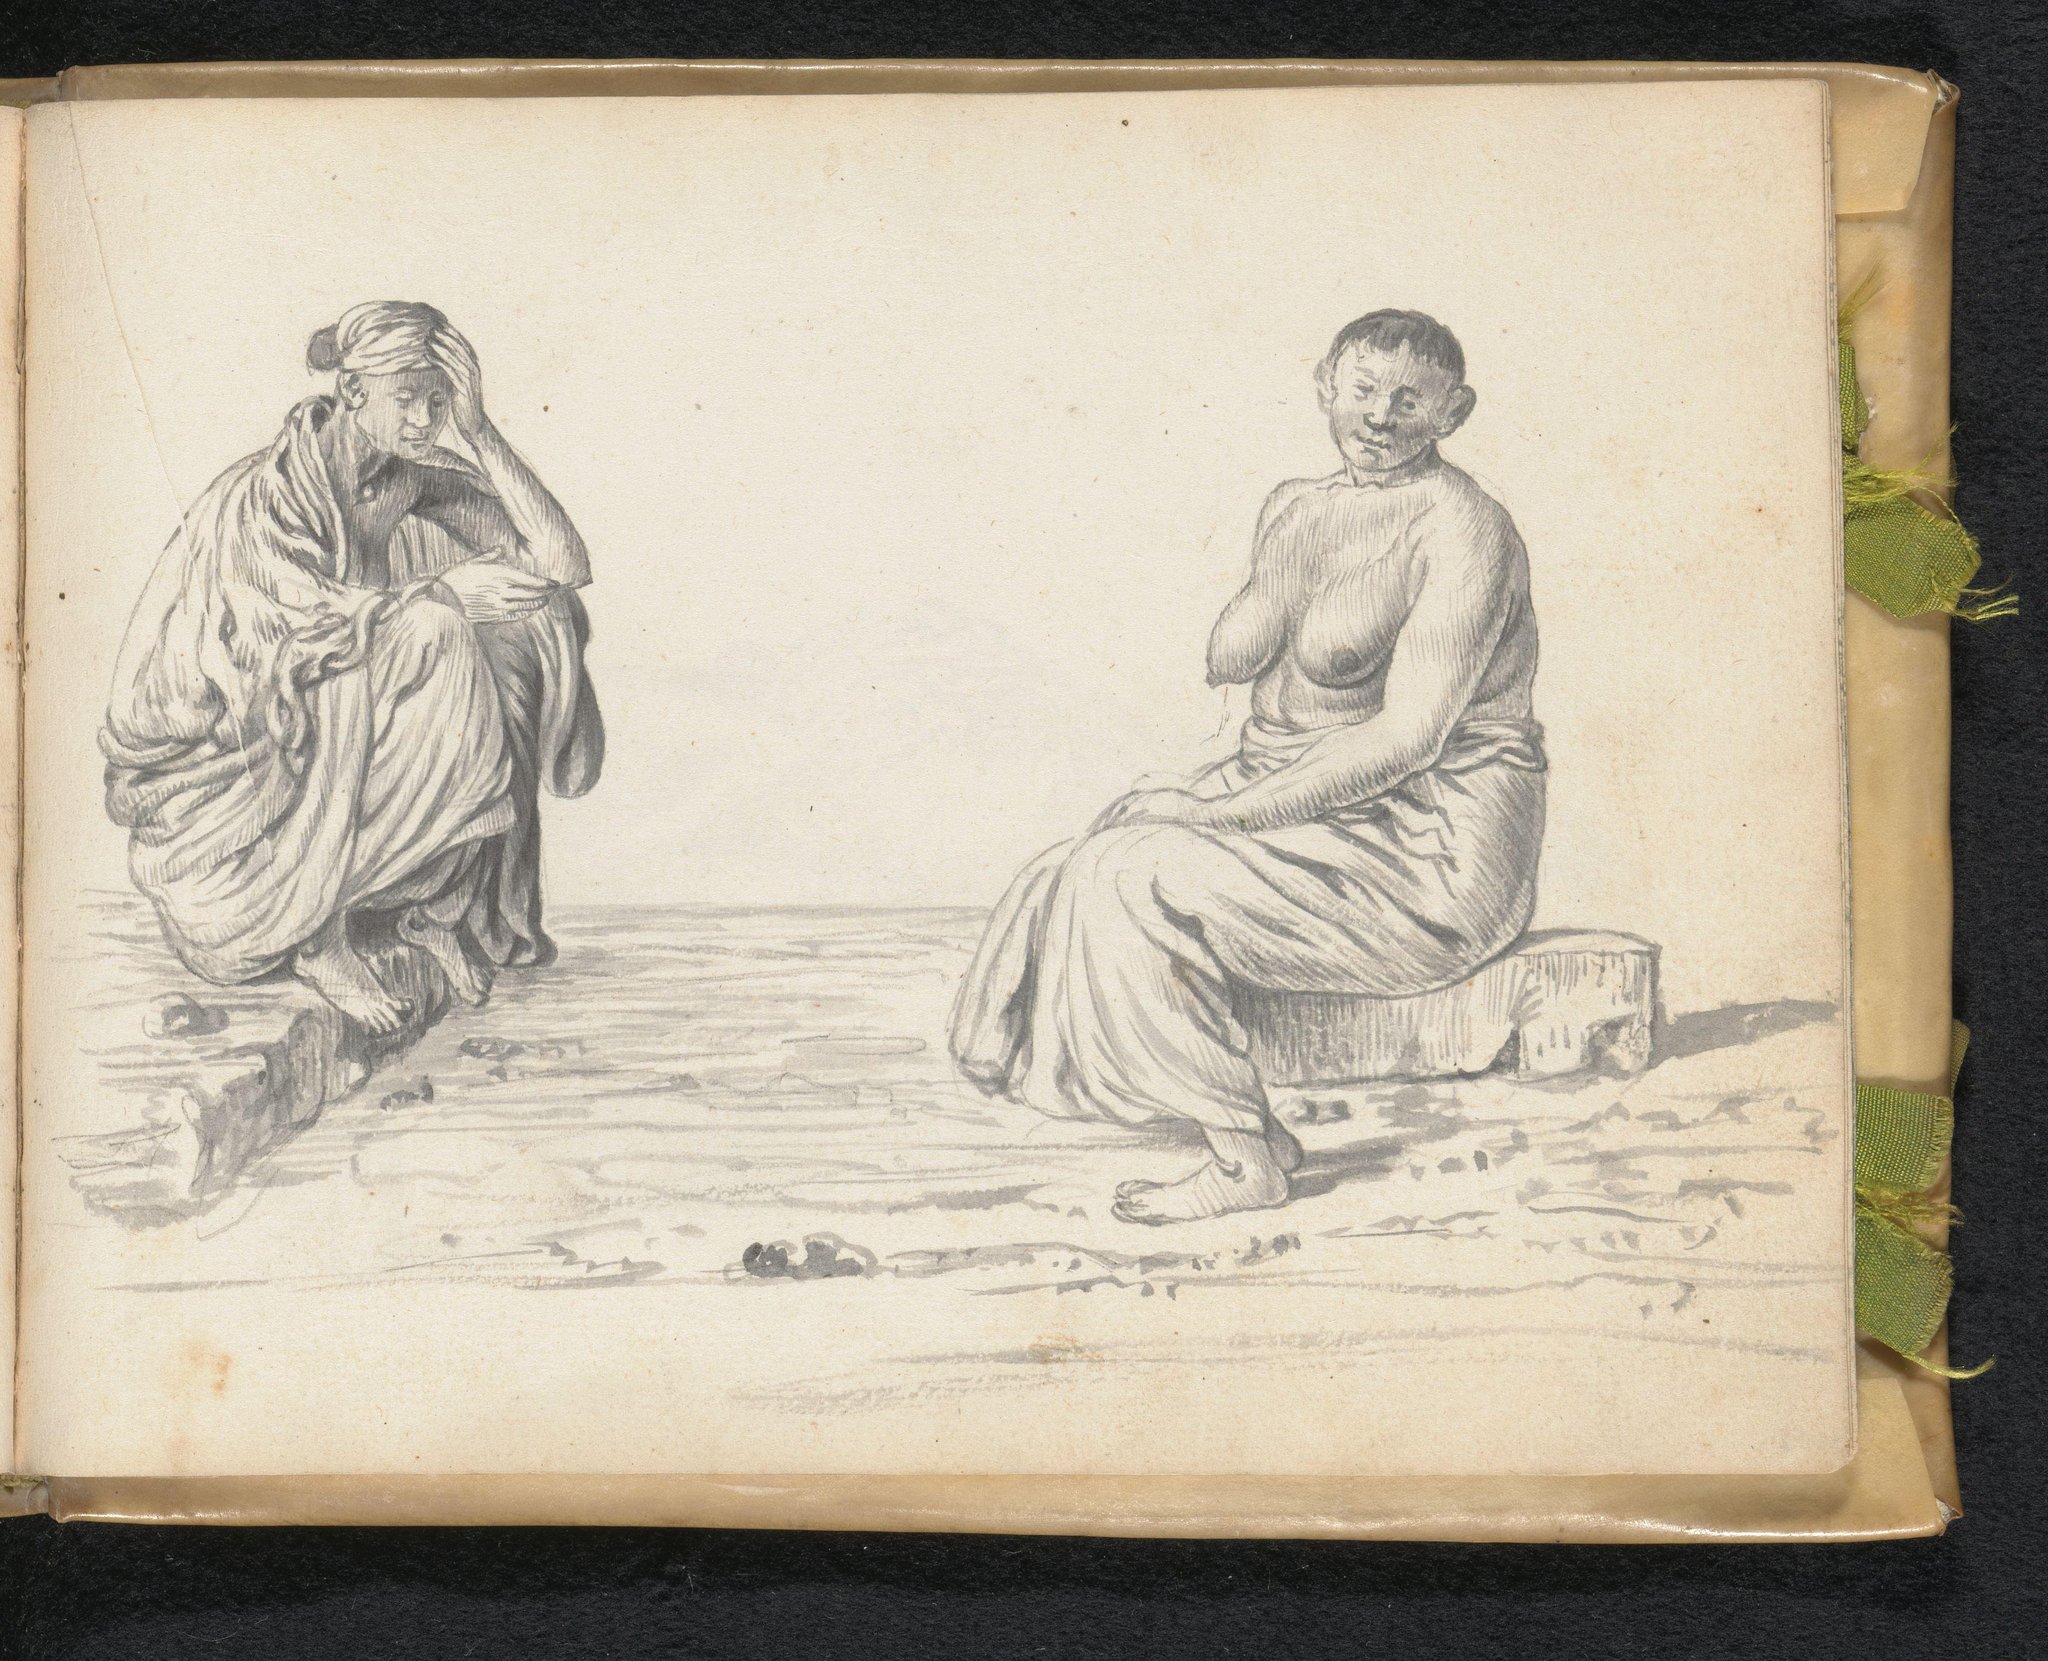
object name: sketchbook leaf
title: Two sitting women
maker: esaias boursse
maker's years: 1631-1672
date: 1662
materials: ink, paper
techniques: brush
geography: sri lanka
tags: asiatic races and peoples (with name), eurasion, half-caste, asian races and peoples (with name), skirt (with name), styles of hairdress (with name) - ~women, wet-nurse, working class, labourers - aa - women, sri lanka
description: Buiten op straat of vlak bij huis zitten twee vrouwen. Linkst hurkt een magere vrouw op een stenen stoeprand. Om haar opgetrokken knieën hangt een wikkelrok (redda). Om haar bovenlijf draagt ze een brede loshangende schouderdoek. Er onder zien we haar blote schouder, hals en gebogen linkerarm. De vrouw draagt een doek op haar hoofd, waaruit vanachter een knot haar steekt (condé). Rechts zit een vrouw op een langwerpig blok steen, met gebogen knieën. Haar enige kledingstuk is een voetlange wikkelrok (redda). Haar bovenlijf met volle borsten is onbedekt. Wellicht is het een voedster (min). De afkomst van beide vrouwen is onduidelijk: mogelijk Euraziatisch, Singalees van lage kaste, of Tamil uit Jaffna. Blad 113 uit een schetsboek met 117 bladen.